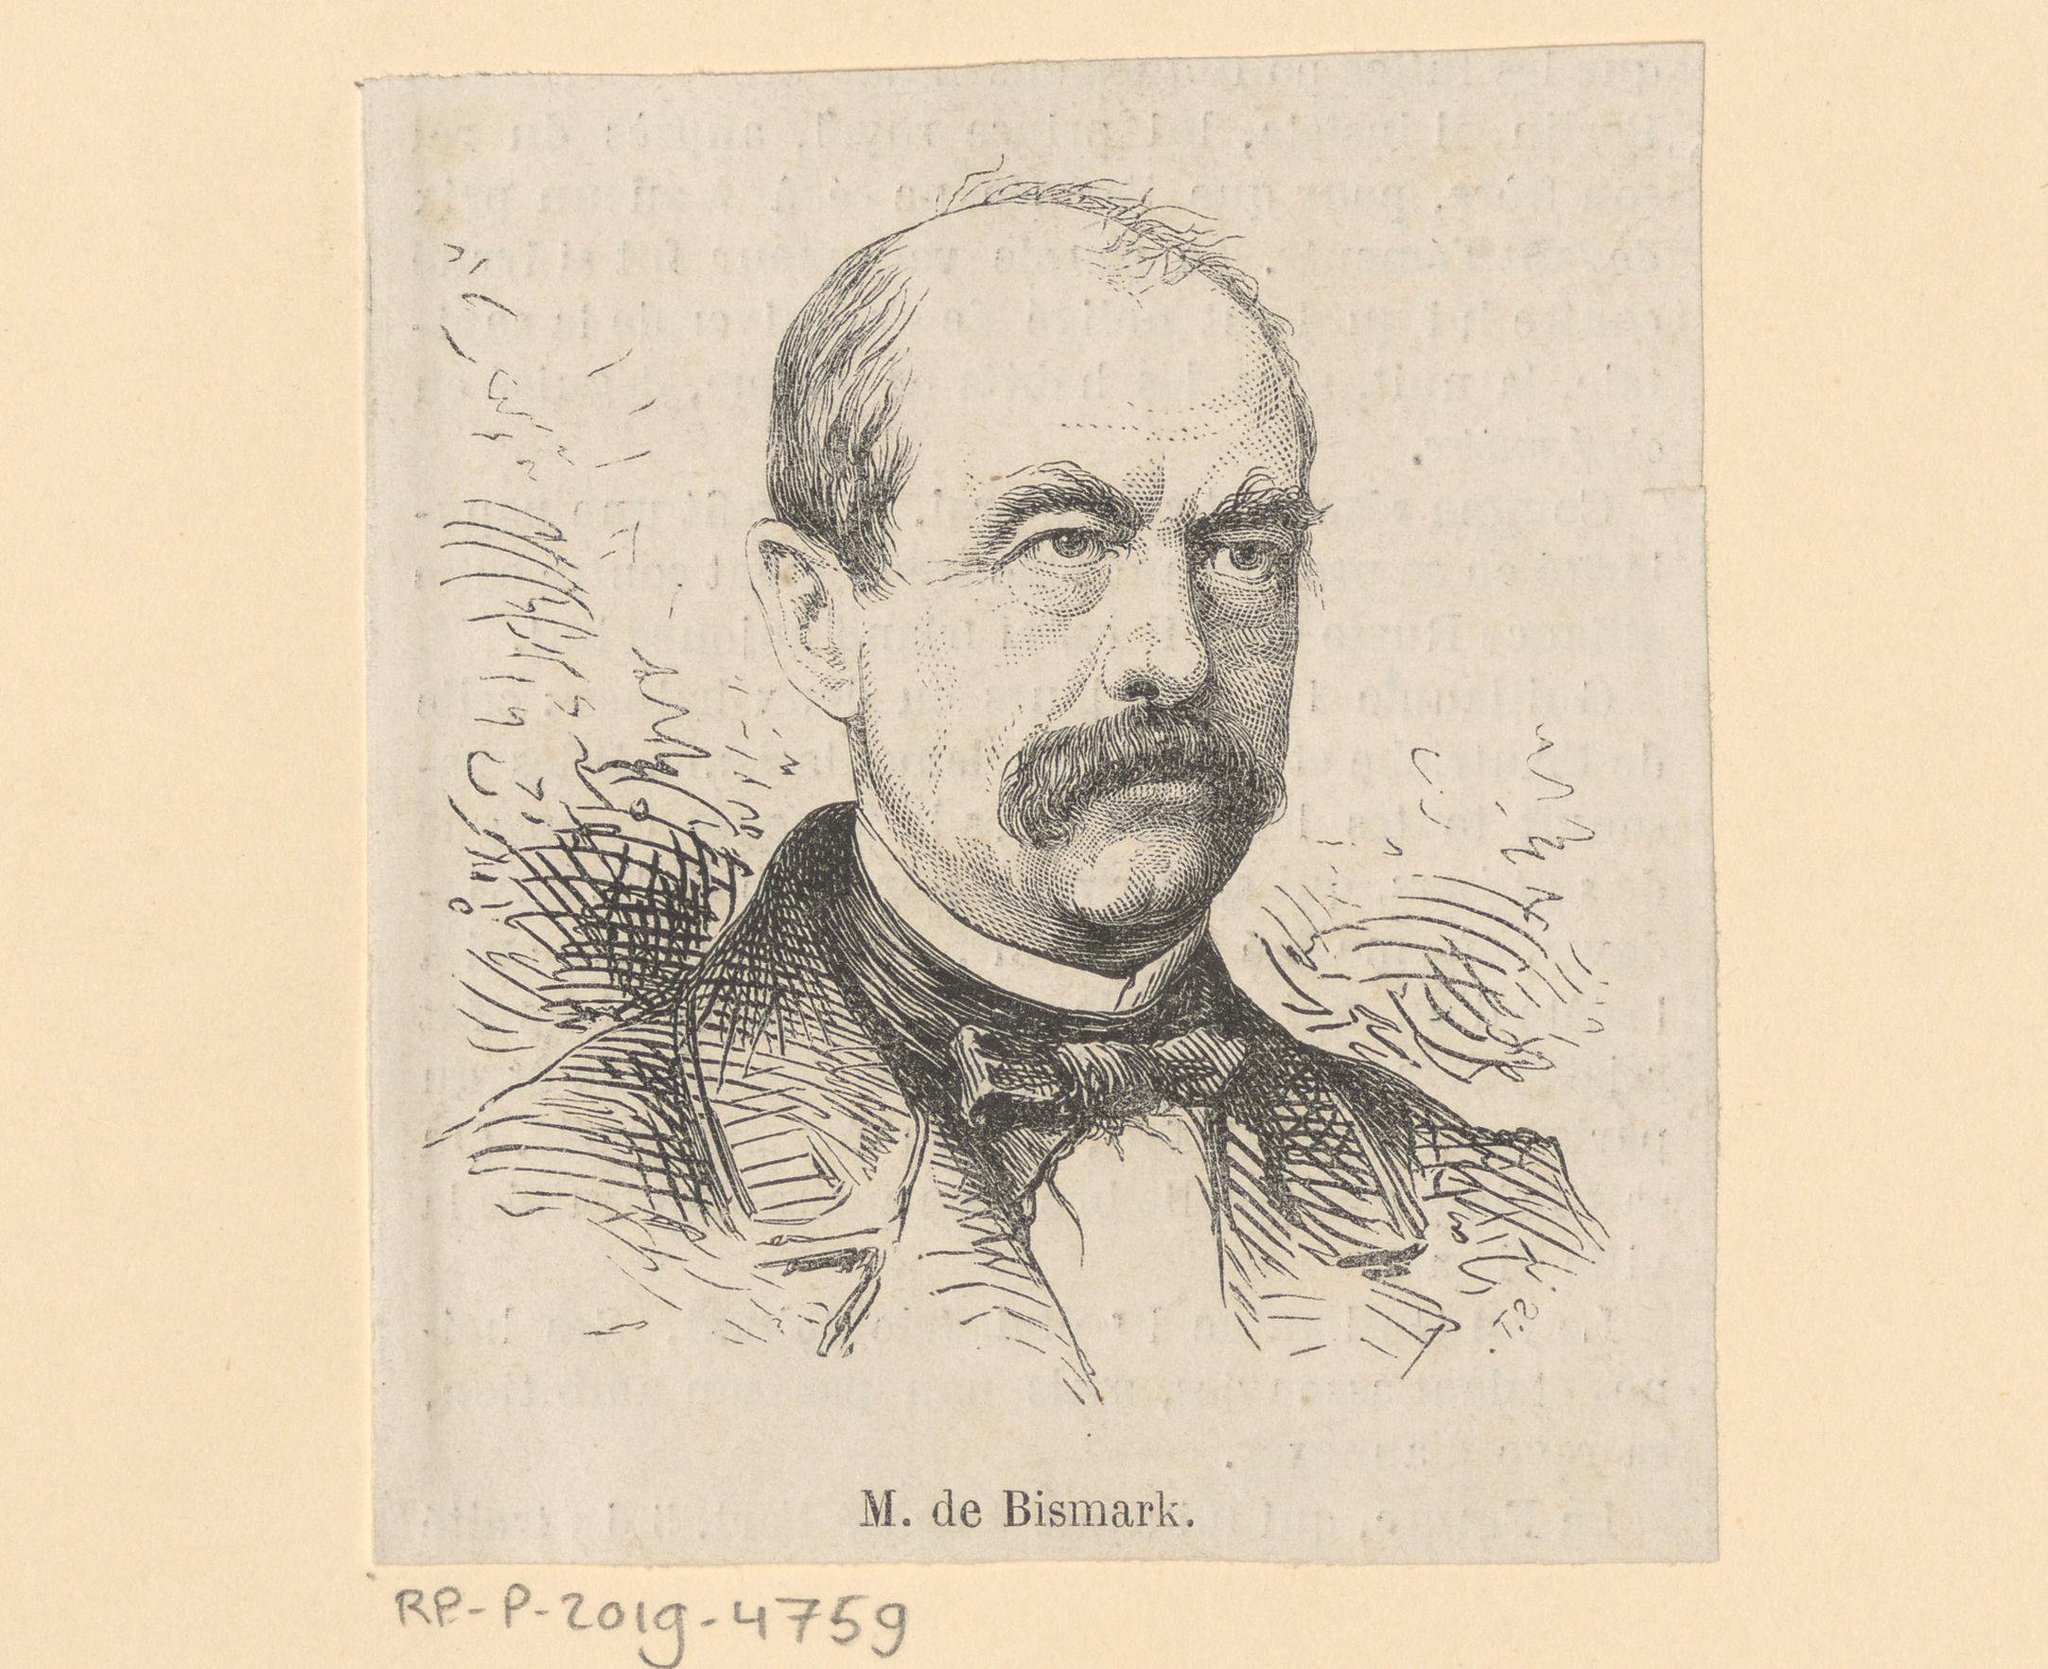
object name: print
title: Portret van Otto von Bismarck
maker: Anonymous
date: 1870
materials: paper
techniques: letterpress printing, engraving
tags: historical persons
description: Prent uit: Le monde illustré, journal hebdomadaire, nr. 696, 15 augustus 1870, p. 104.